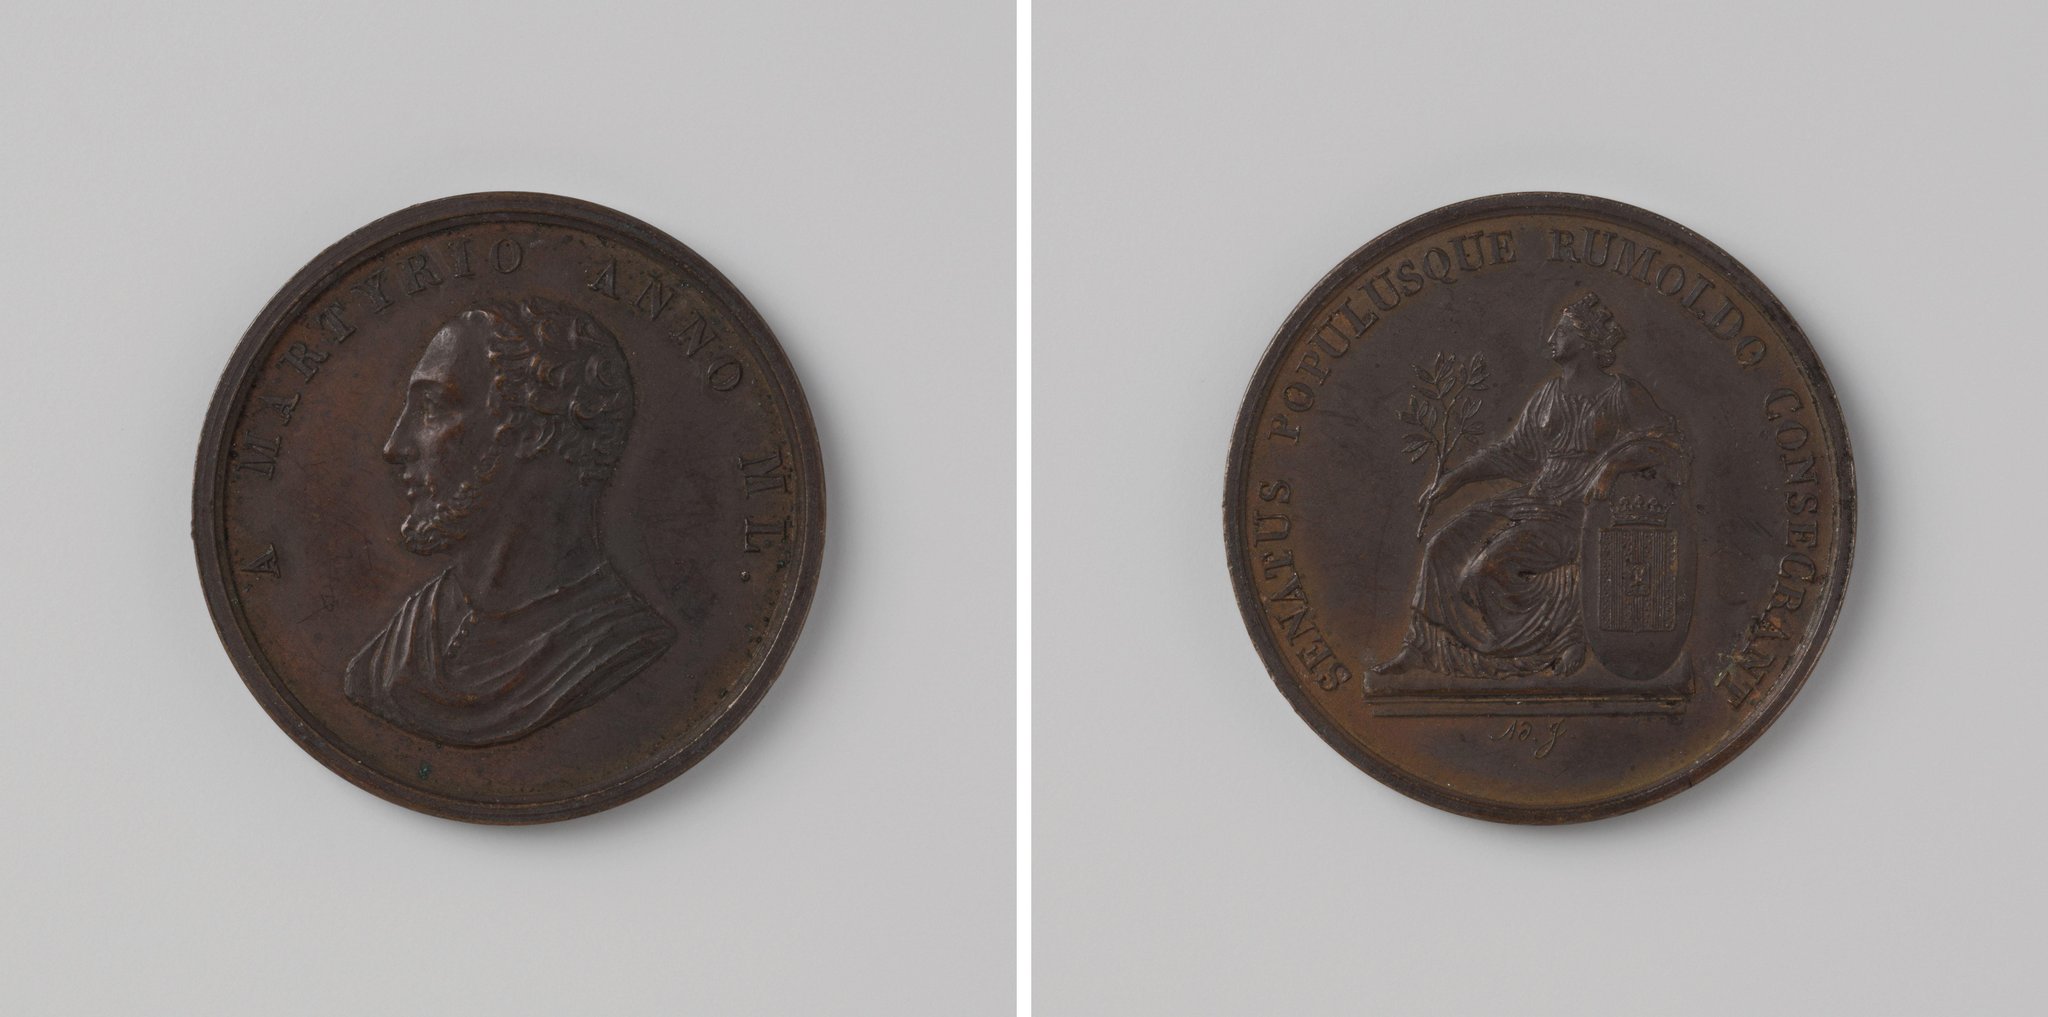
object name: history medal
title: Duizendvijftigjarige viering van het martelaarschap van St. Rumoldus, patroon van de stad Mechelen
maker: adolphe jouvenel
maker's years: 1798-1867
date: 1825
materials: silver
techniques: striking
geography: belgium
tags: mechelen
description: Zilveren penning. Voorzijde: borststuk man binnen omschrift. Keerzijde: gekroonde vrouw met olijftak en wapenschild binnen omschrift; afsnede: signatuur.